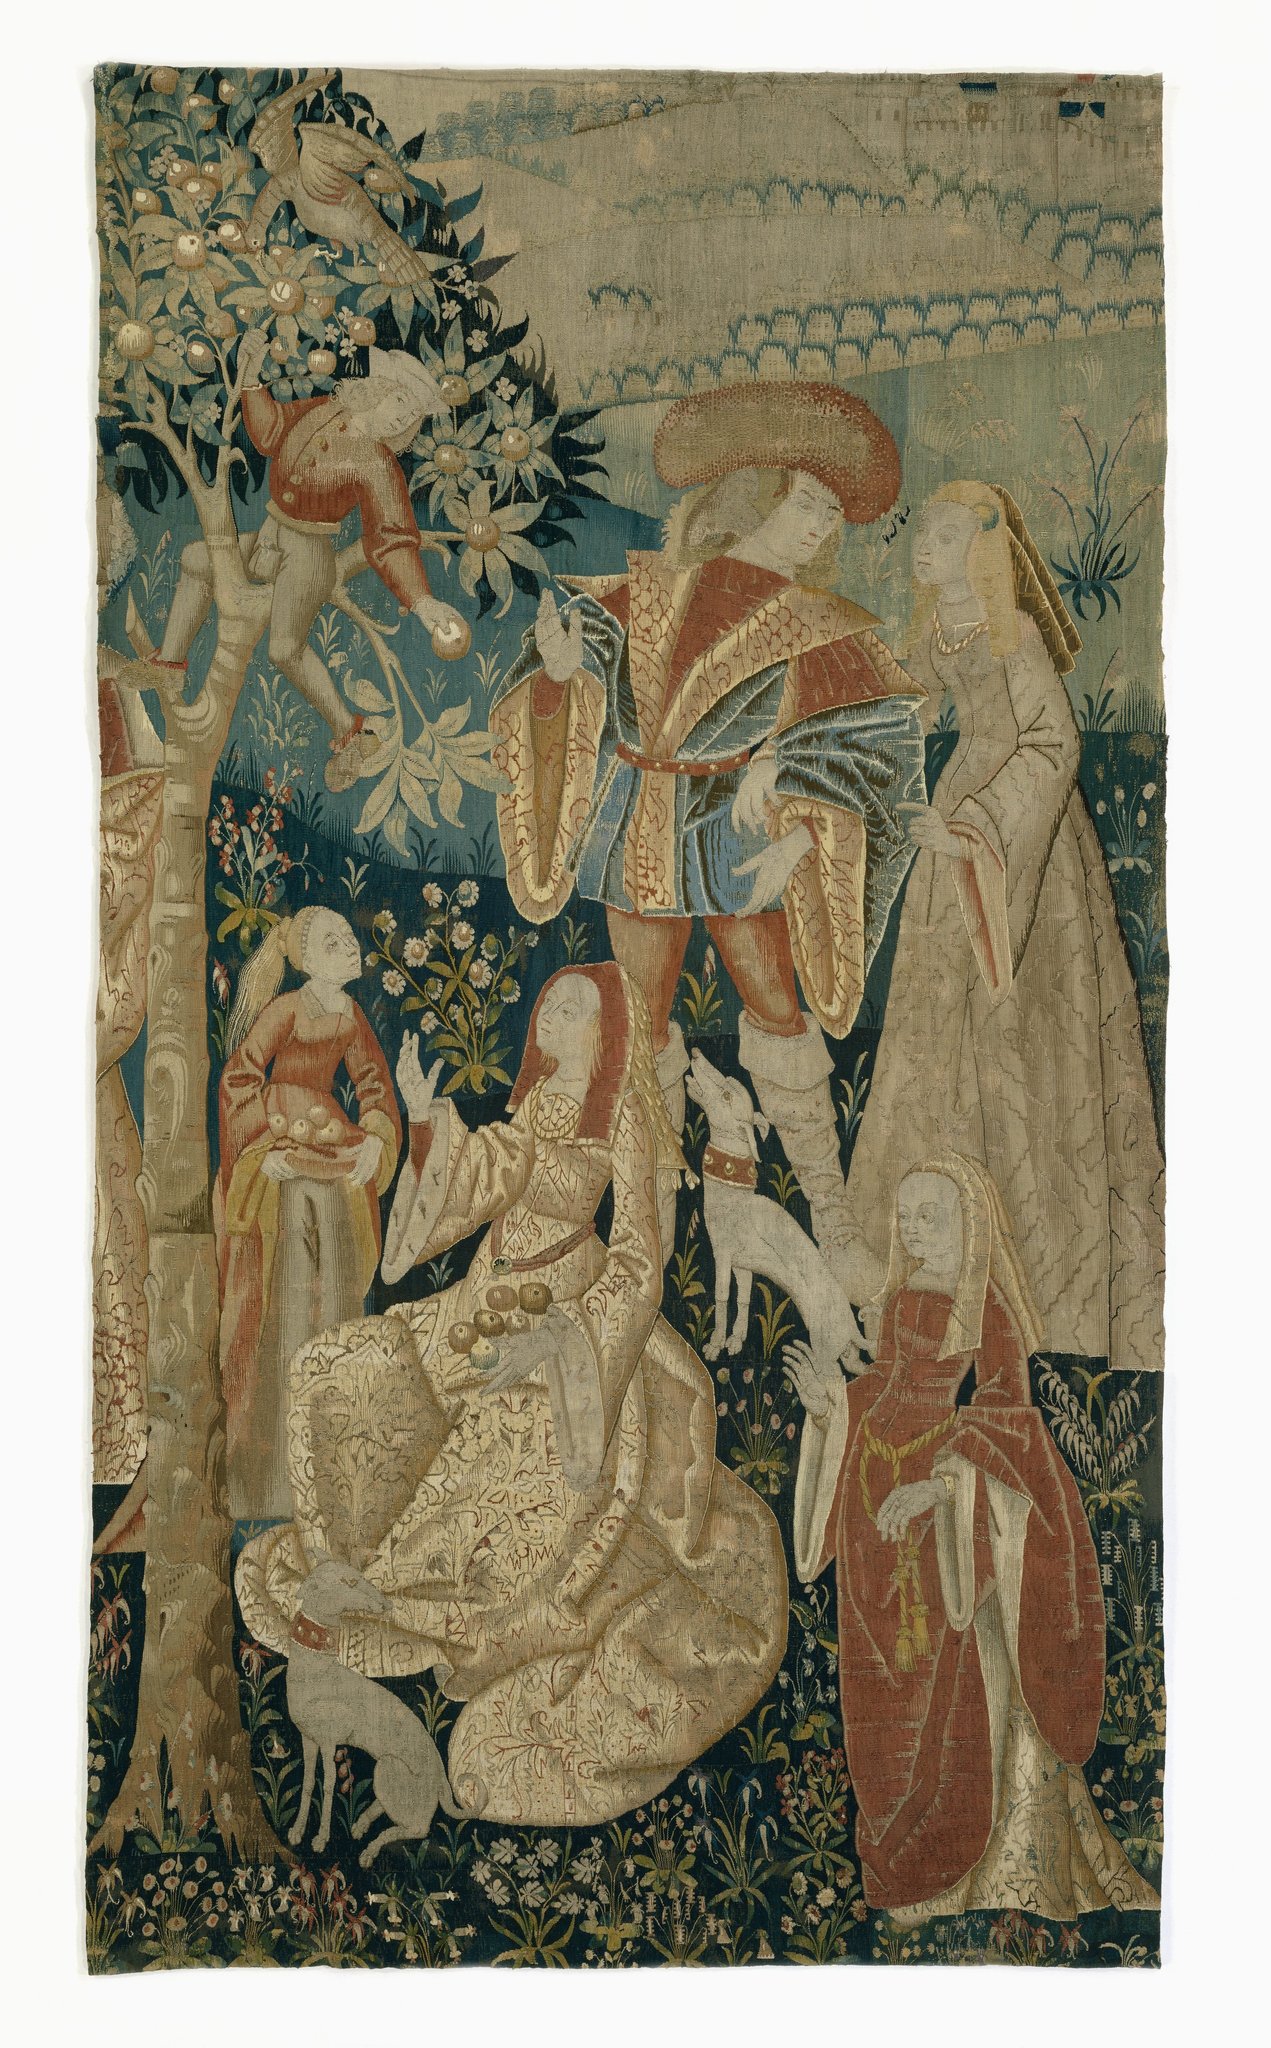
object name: tapestry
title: De sinaasappelpluk (fragment)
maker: Anonymous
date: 1500-1525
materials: silk, wool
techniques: tapestry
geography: southern netherlands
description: Tapestry (fragment). Picking oranges. Wool, silk. Tournai or Brussels, c. 1490 - 1500.